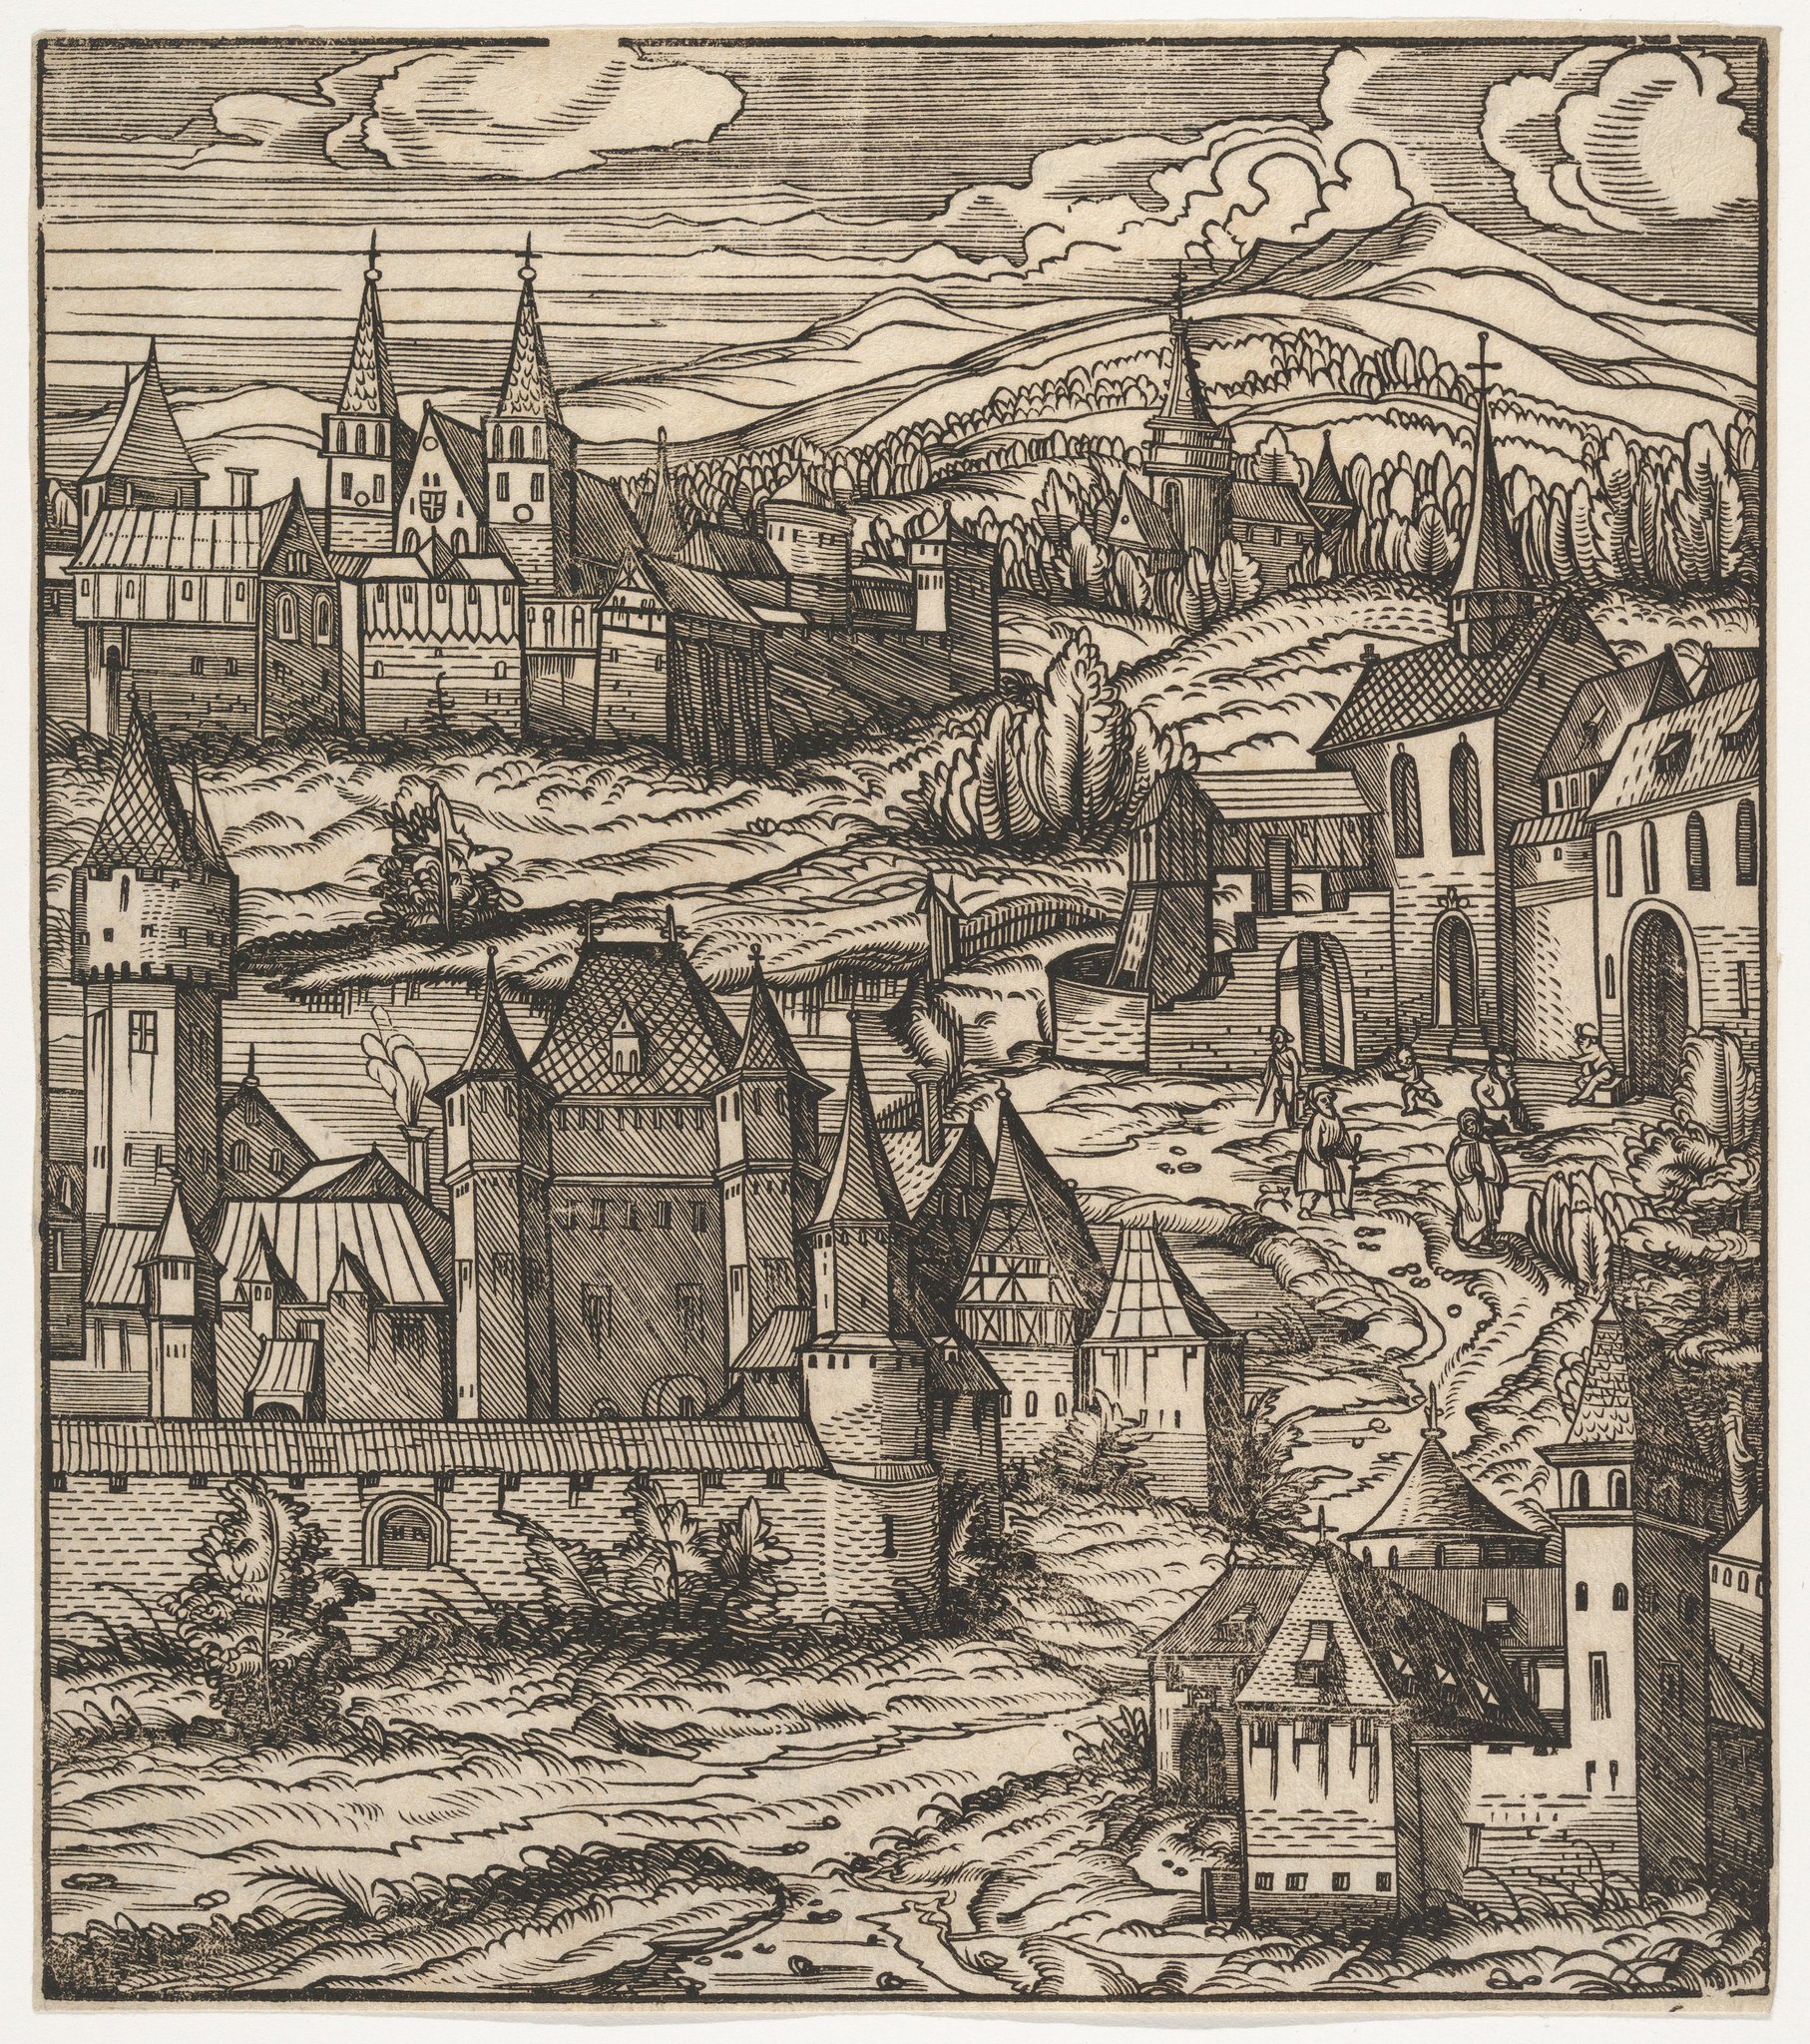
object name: print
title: The Splendid Foundation of the Old White King, from "Der Weisskunig"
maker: hans burgkmair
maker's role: artist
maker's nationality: german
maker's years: 1473-1531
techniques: woodcut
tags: architecture